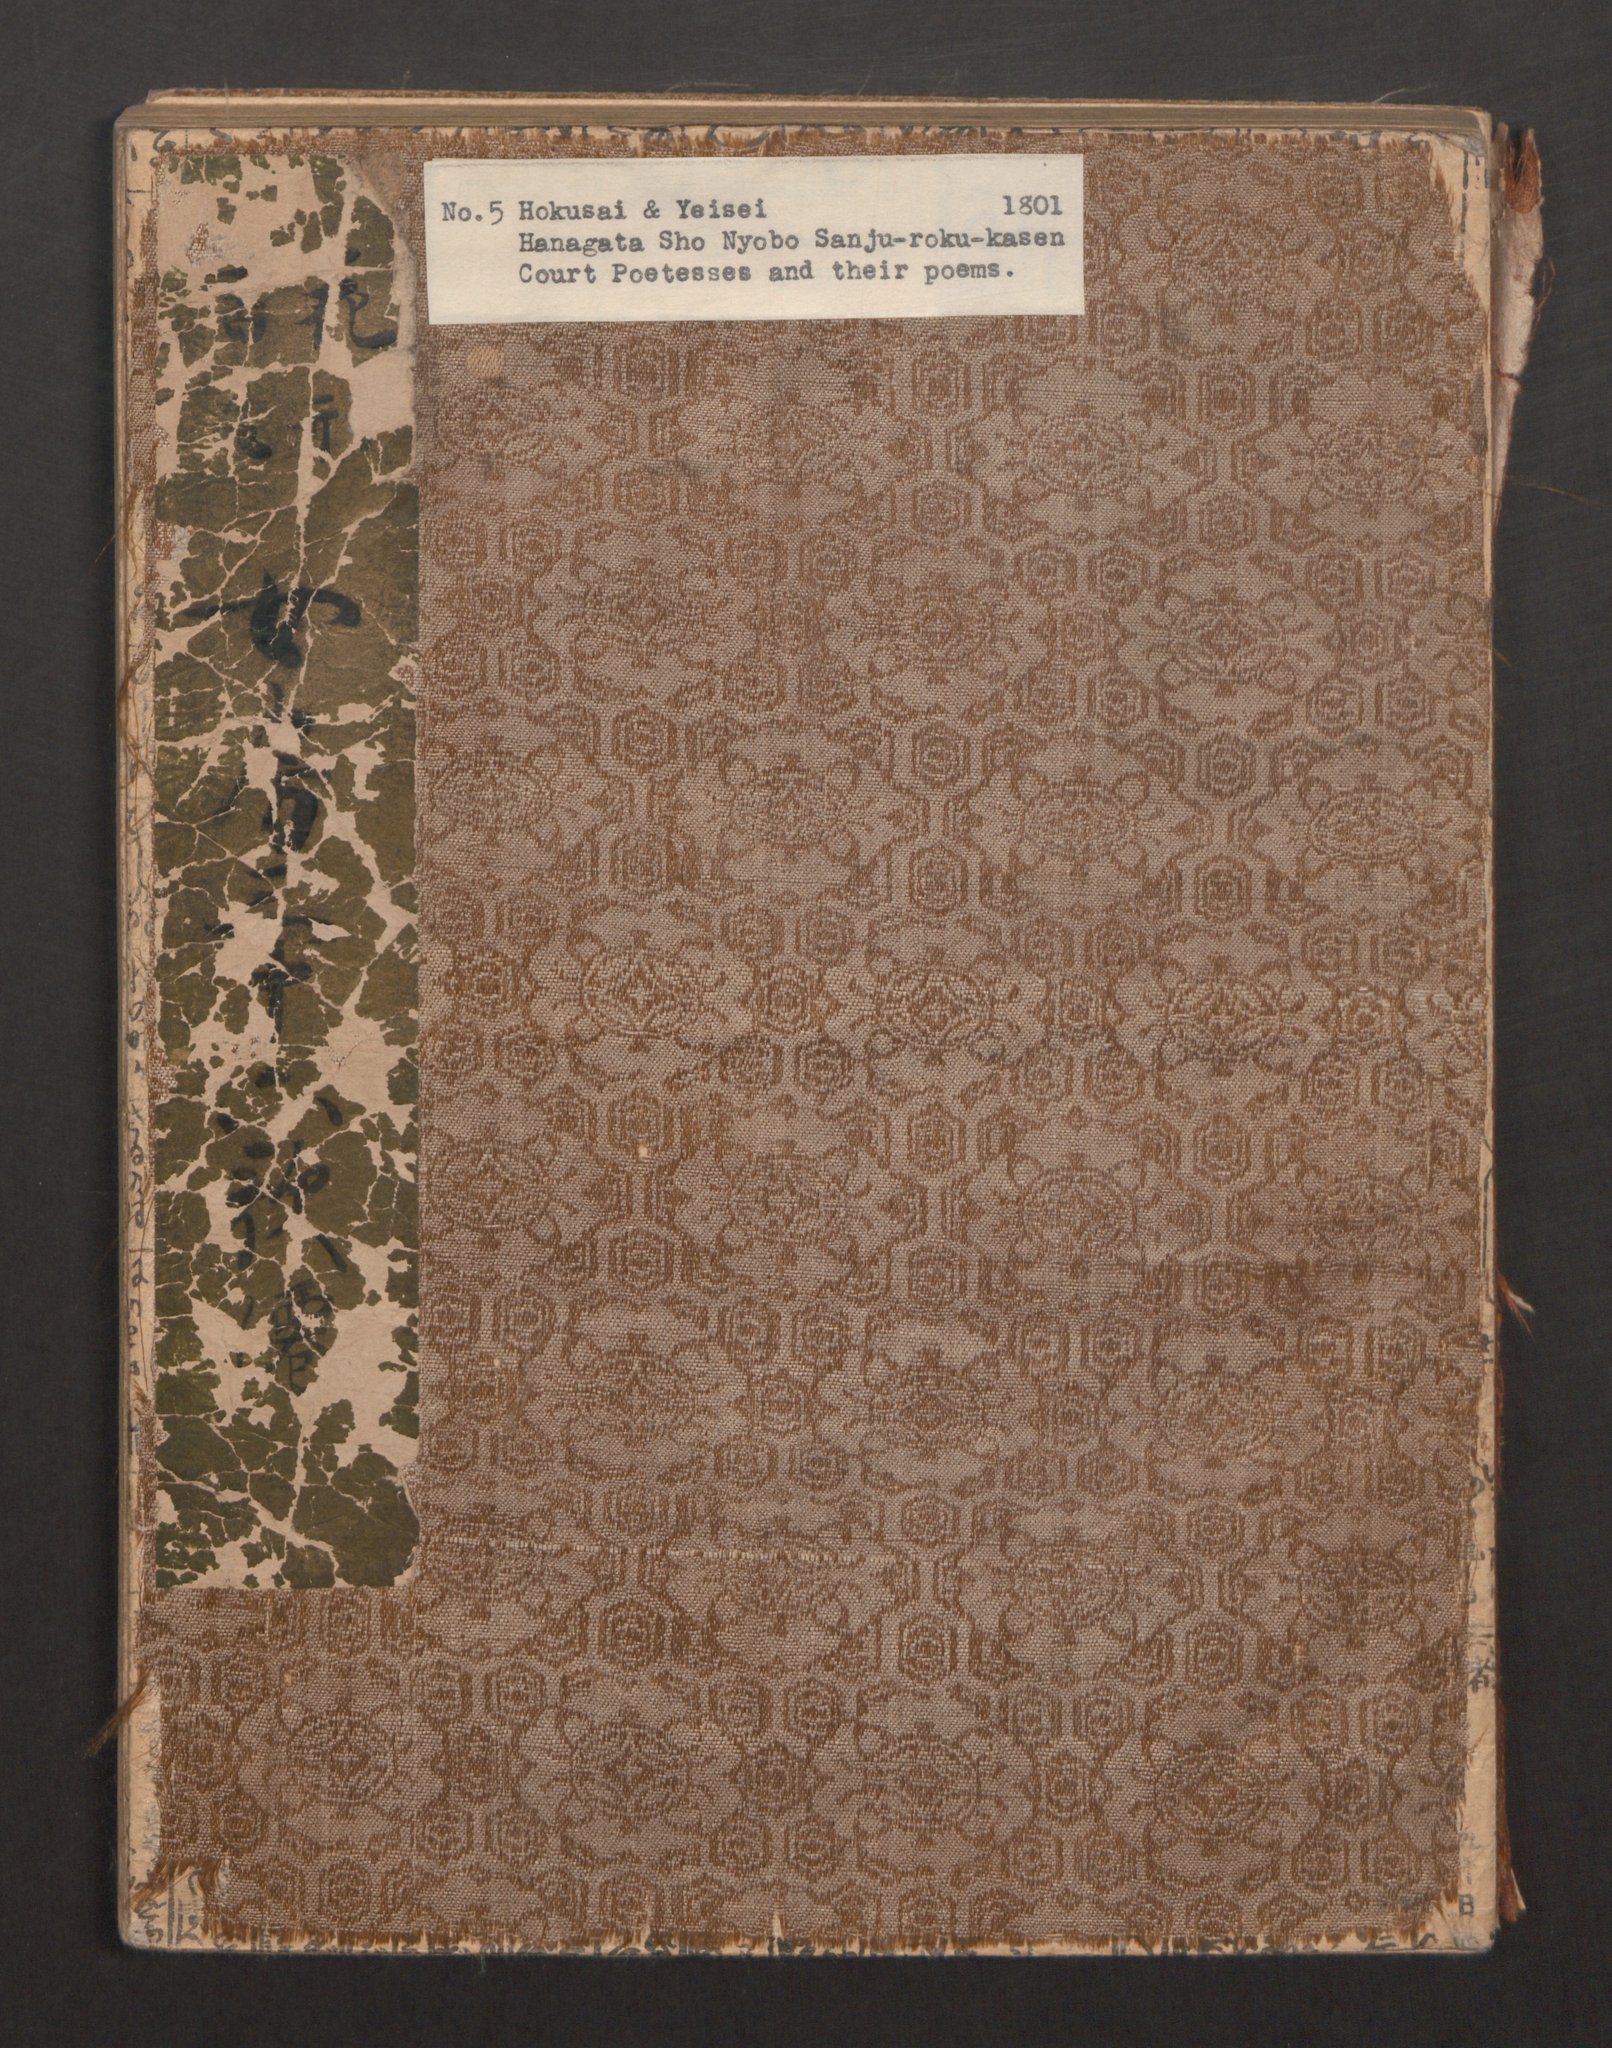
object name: illustrated book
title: Brocade Prints of the Thirty-six Poetesses (Nishiki zuri onna sanjūrokkasen) 錦摺女三十六歌仙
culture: japanese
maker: chōbunsai (hosoda) eishi , 鳥文斎(細田)栄之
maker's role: artist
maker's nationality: japanese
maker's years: 1756-1829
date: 1801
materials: ink, paper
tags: men,women